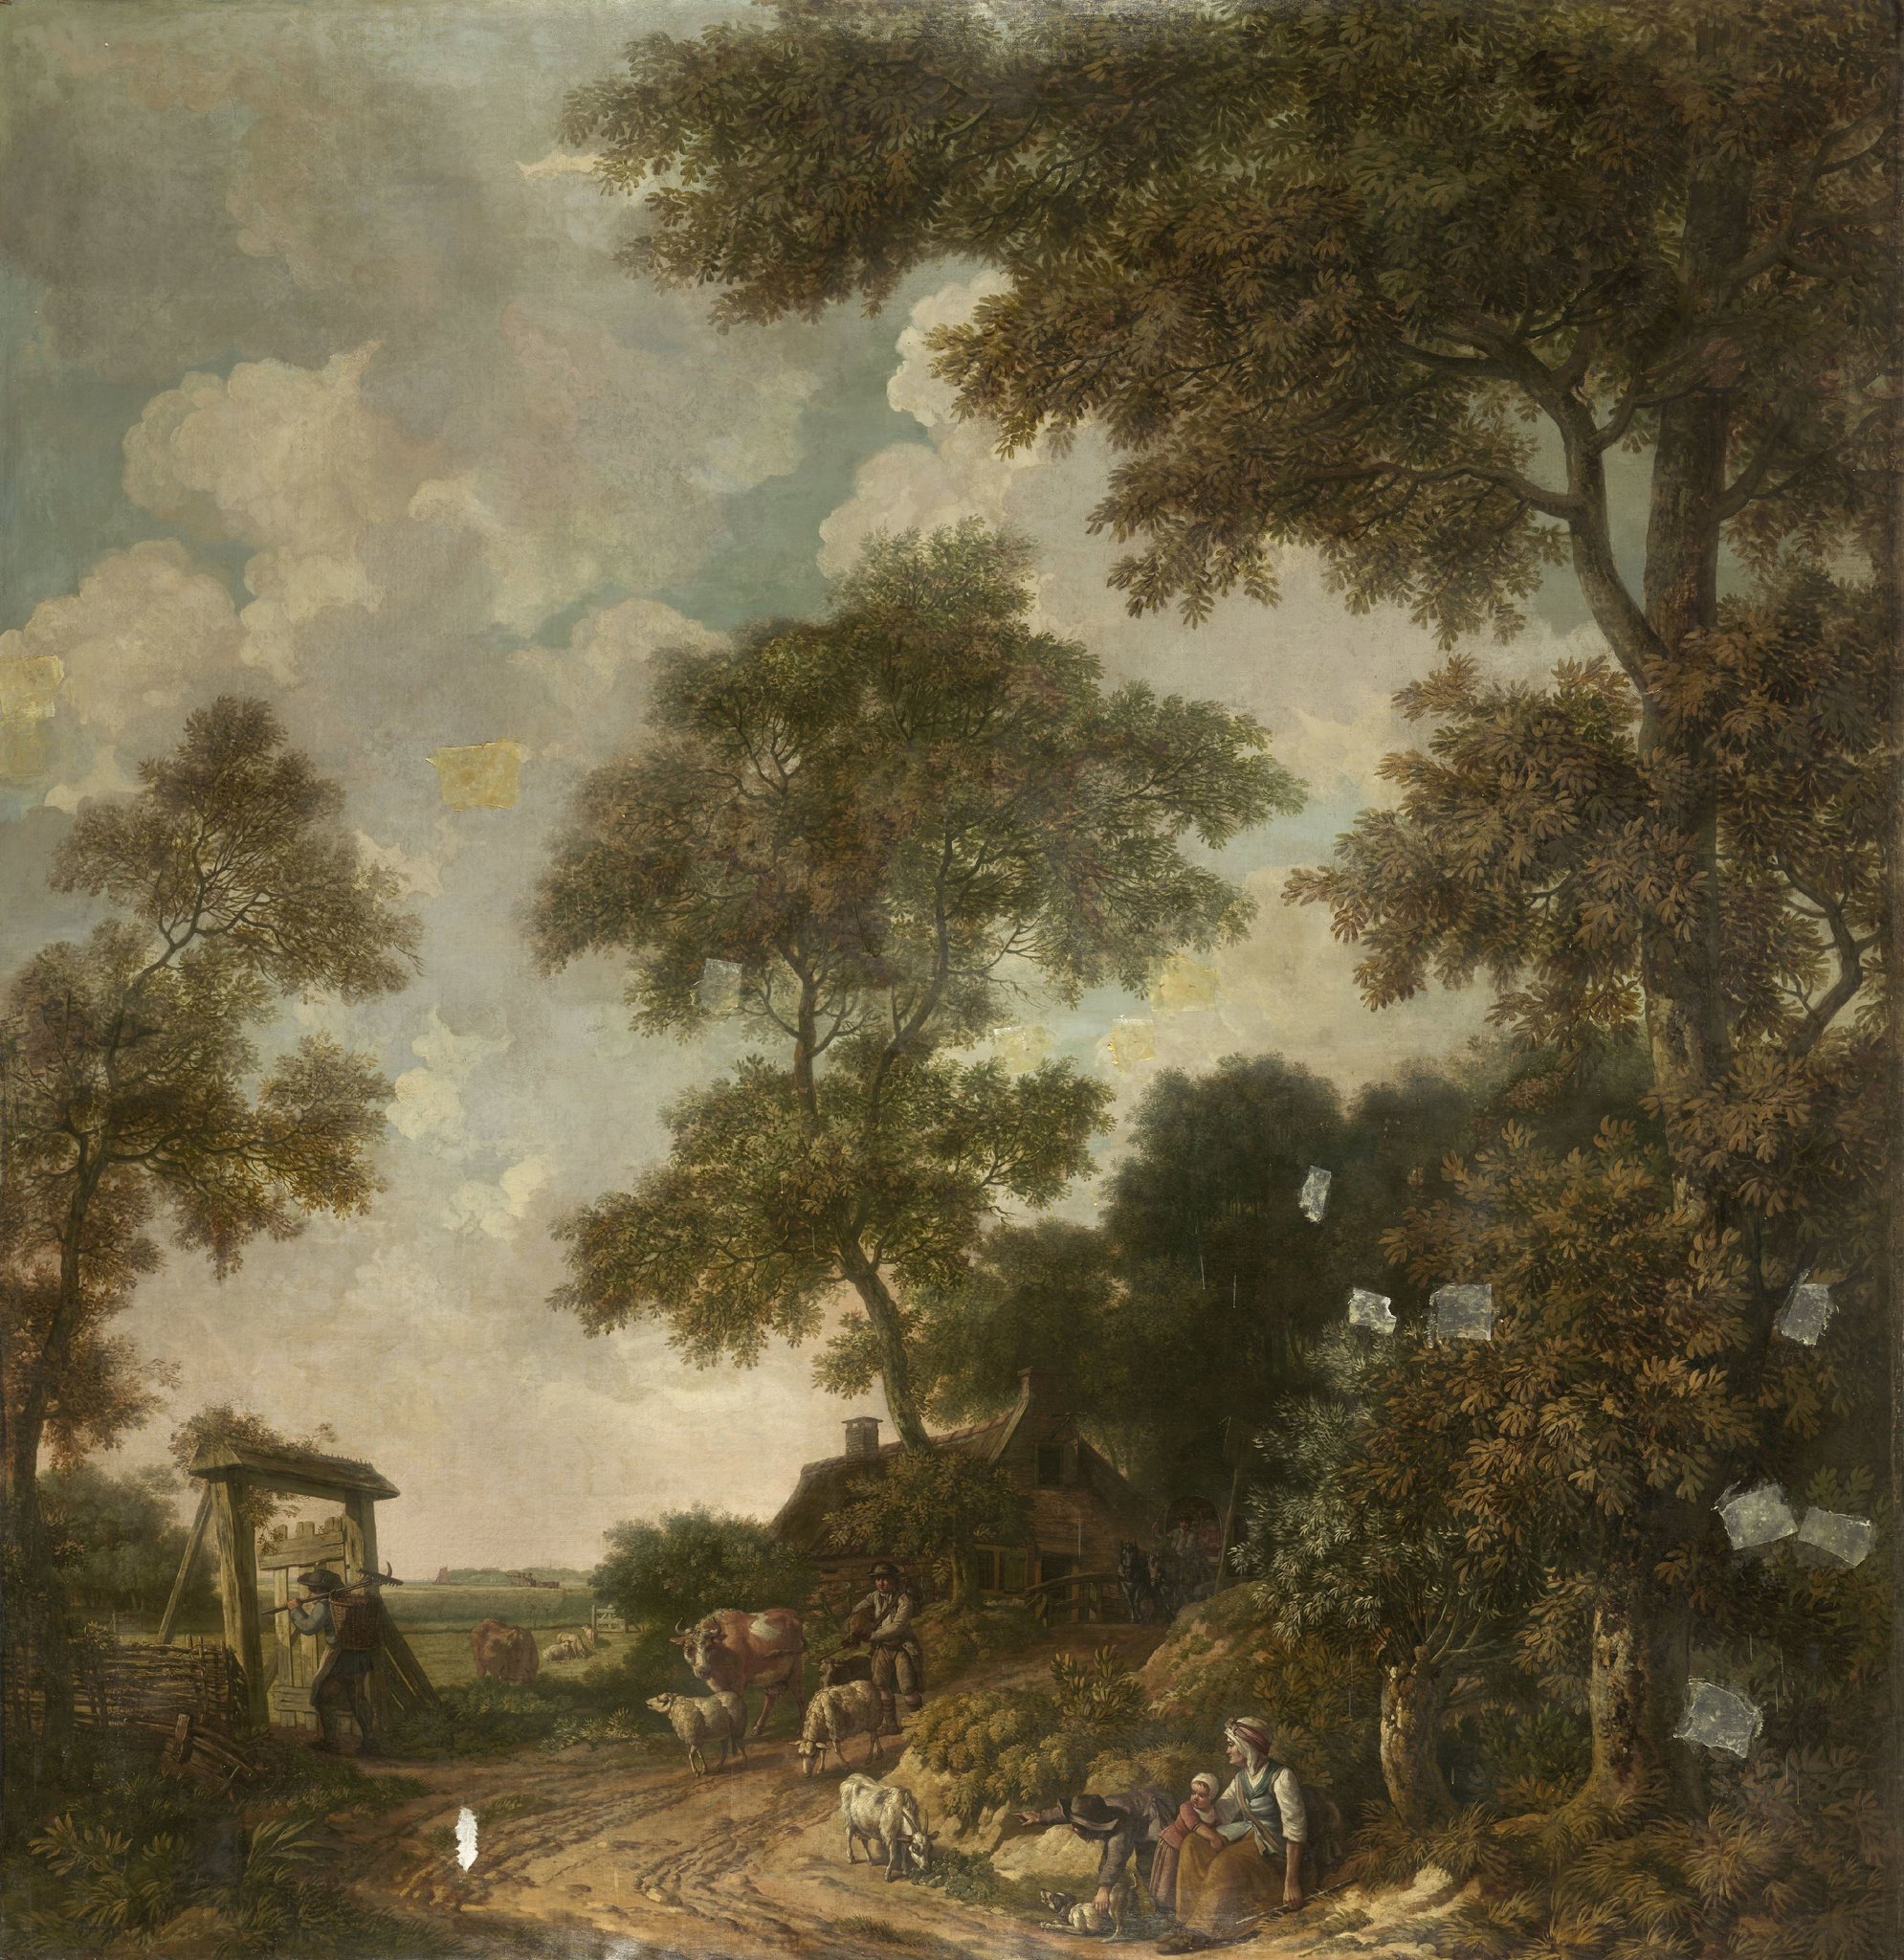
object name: hanging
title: Behangselschildering van een Hollands landschap met een zandweg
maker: jurriaan andriessen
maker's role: draughtsman, painter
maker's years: 1742-1819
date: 1776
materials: canvas, oil, paint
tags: netherlands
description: Behangselschildering van een Hollands landschap met een zandweg, enkele figuren, een boerderij en rechts een begroeide heuvel.